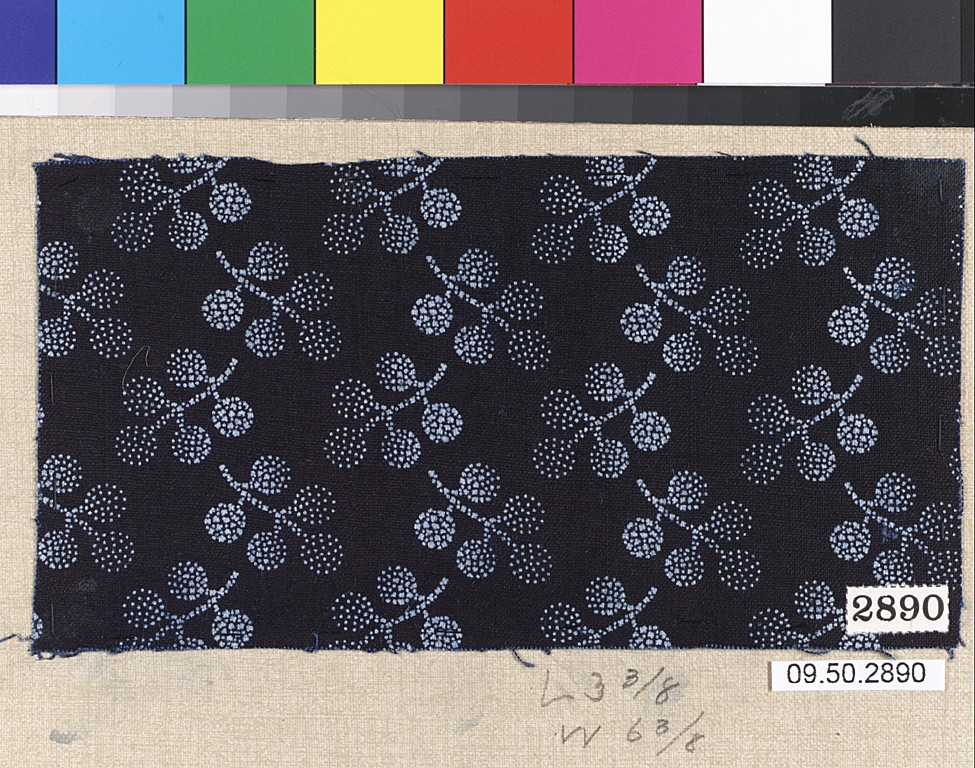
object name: piece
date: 1801-1900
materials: cotton